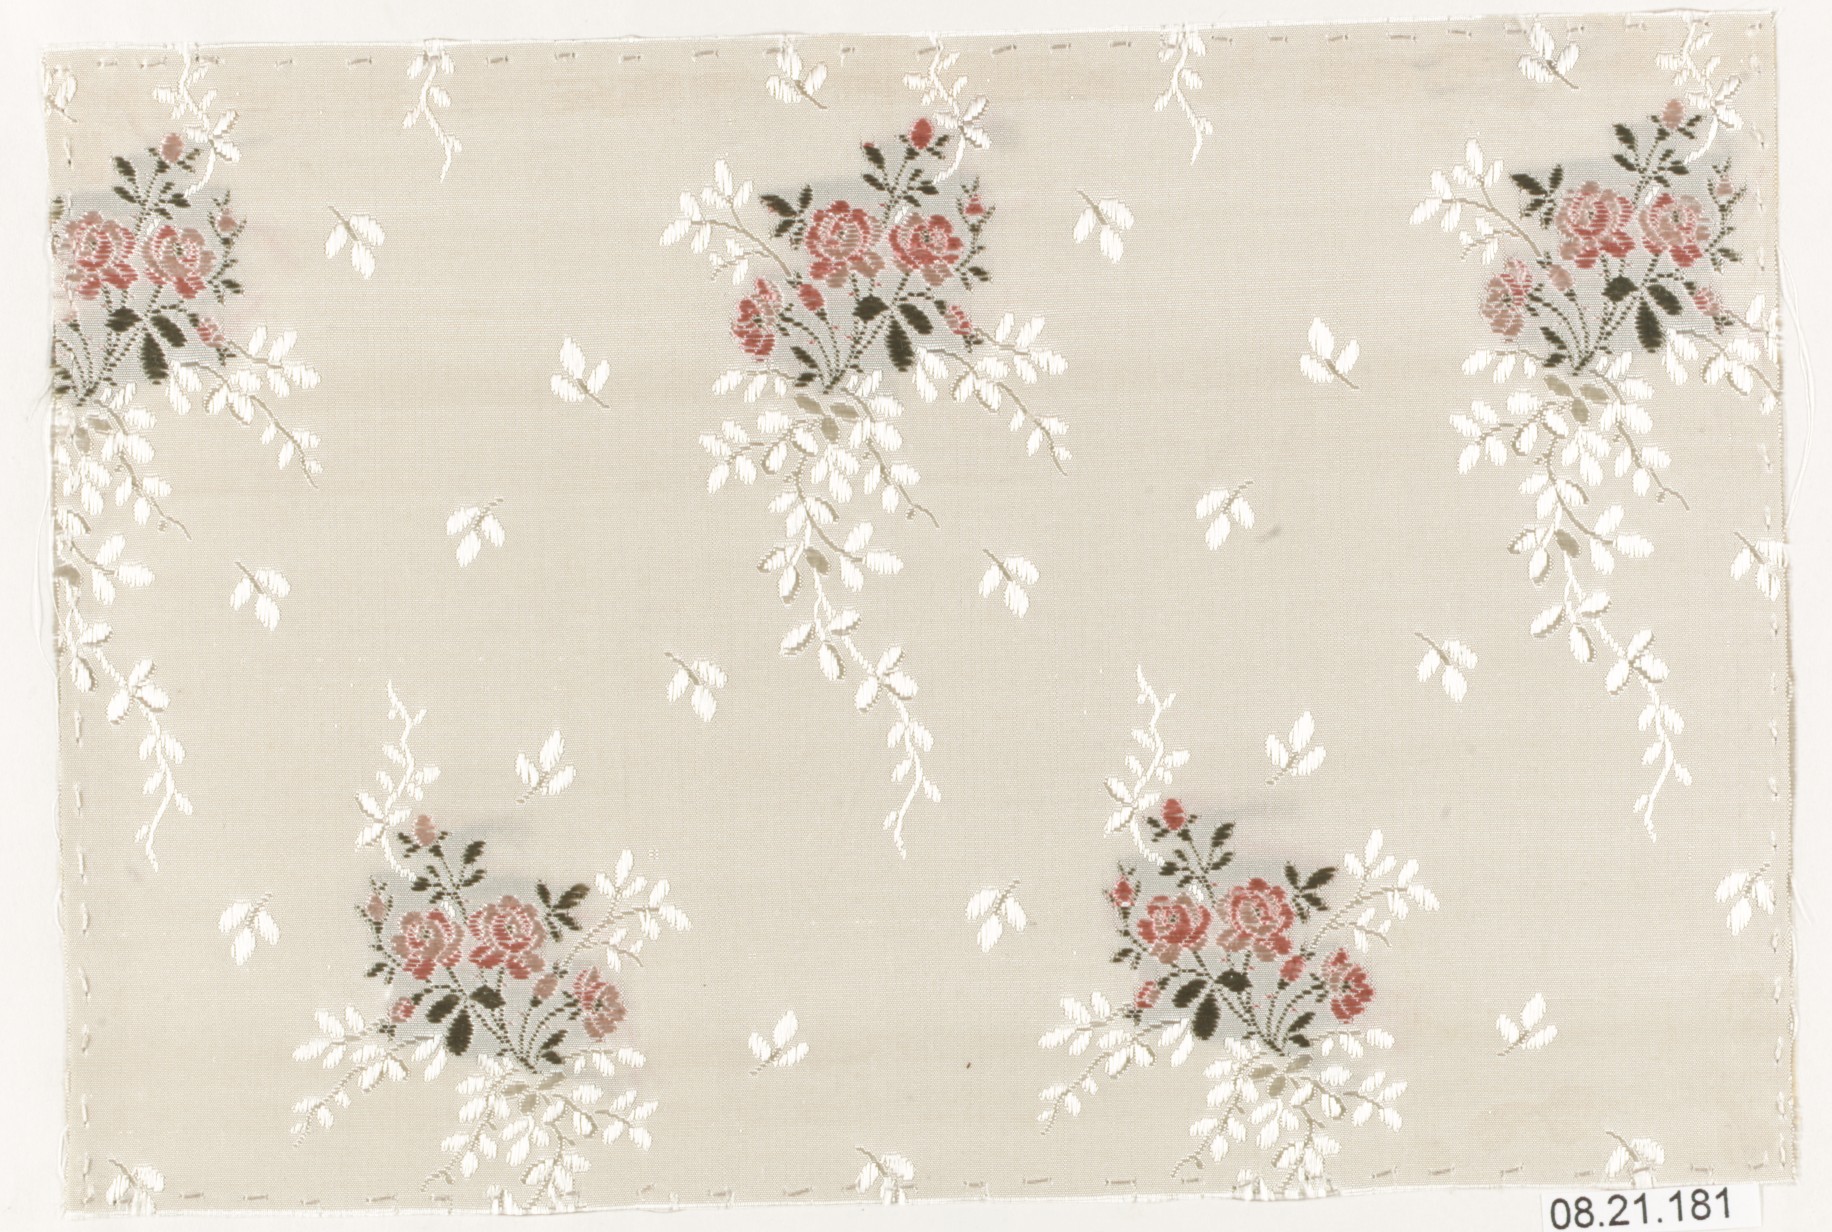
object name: textile sample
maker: Anonymous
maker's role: designer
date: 1900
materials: silk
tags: flowers